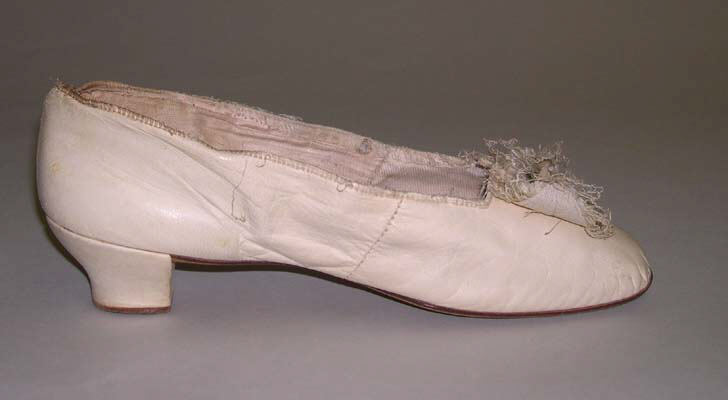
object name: slipper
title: Slippers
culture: american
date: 1872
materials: leather, silk